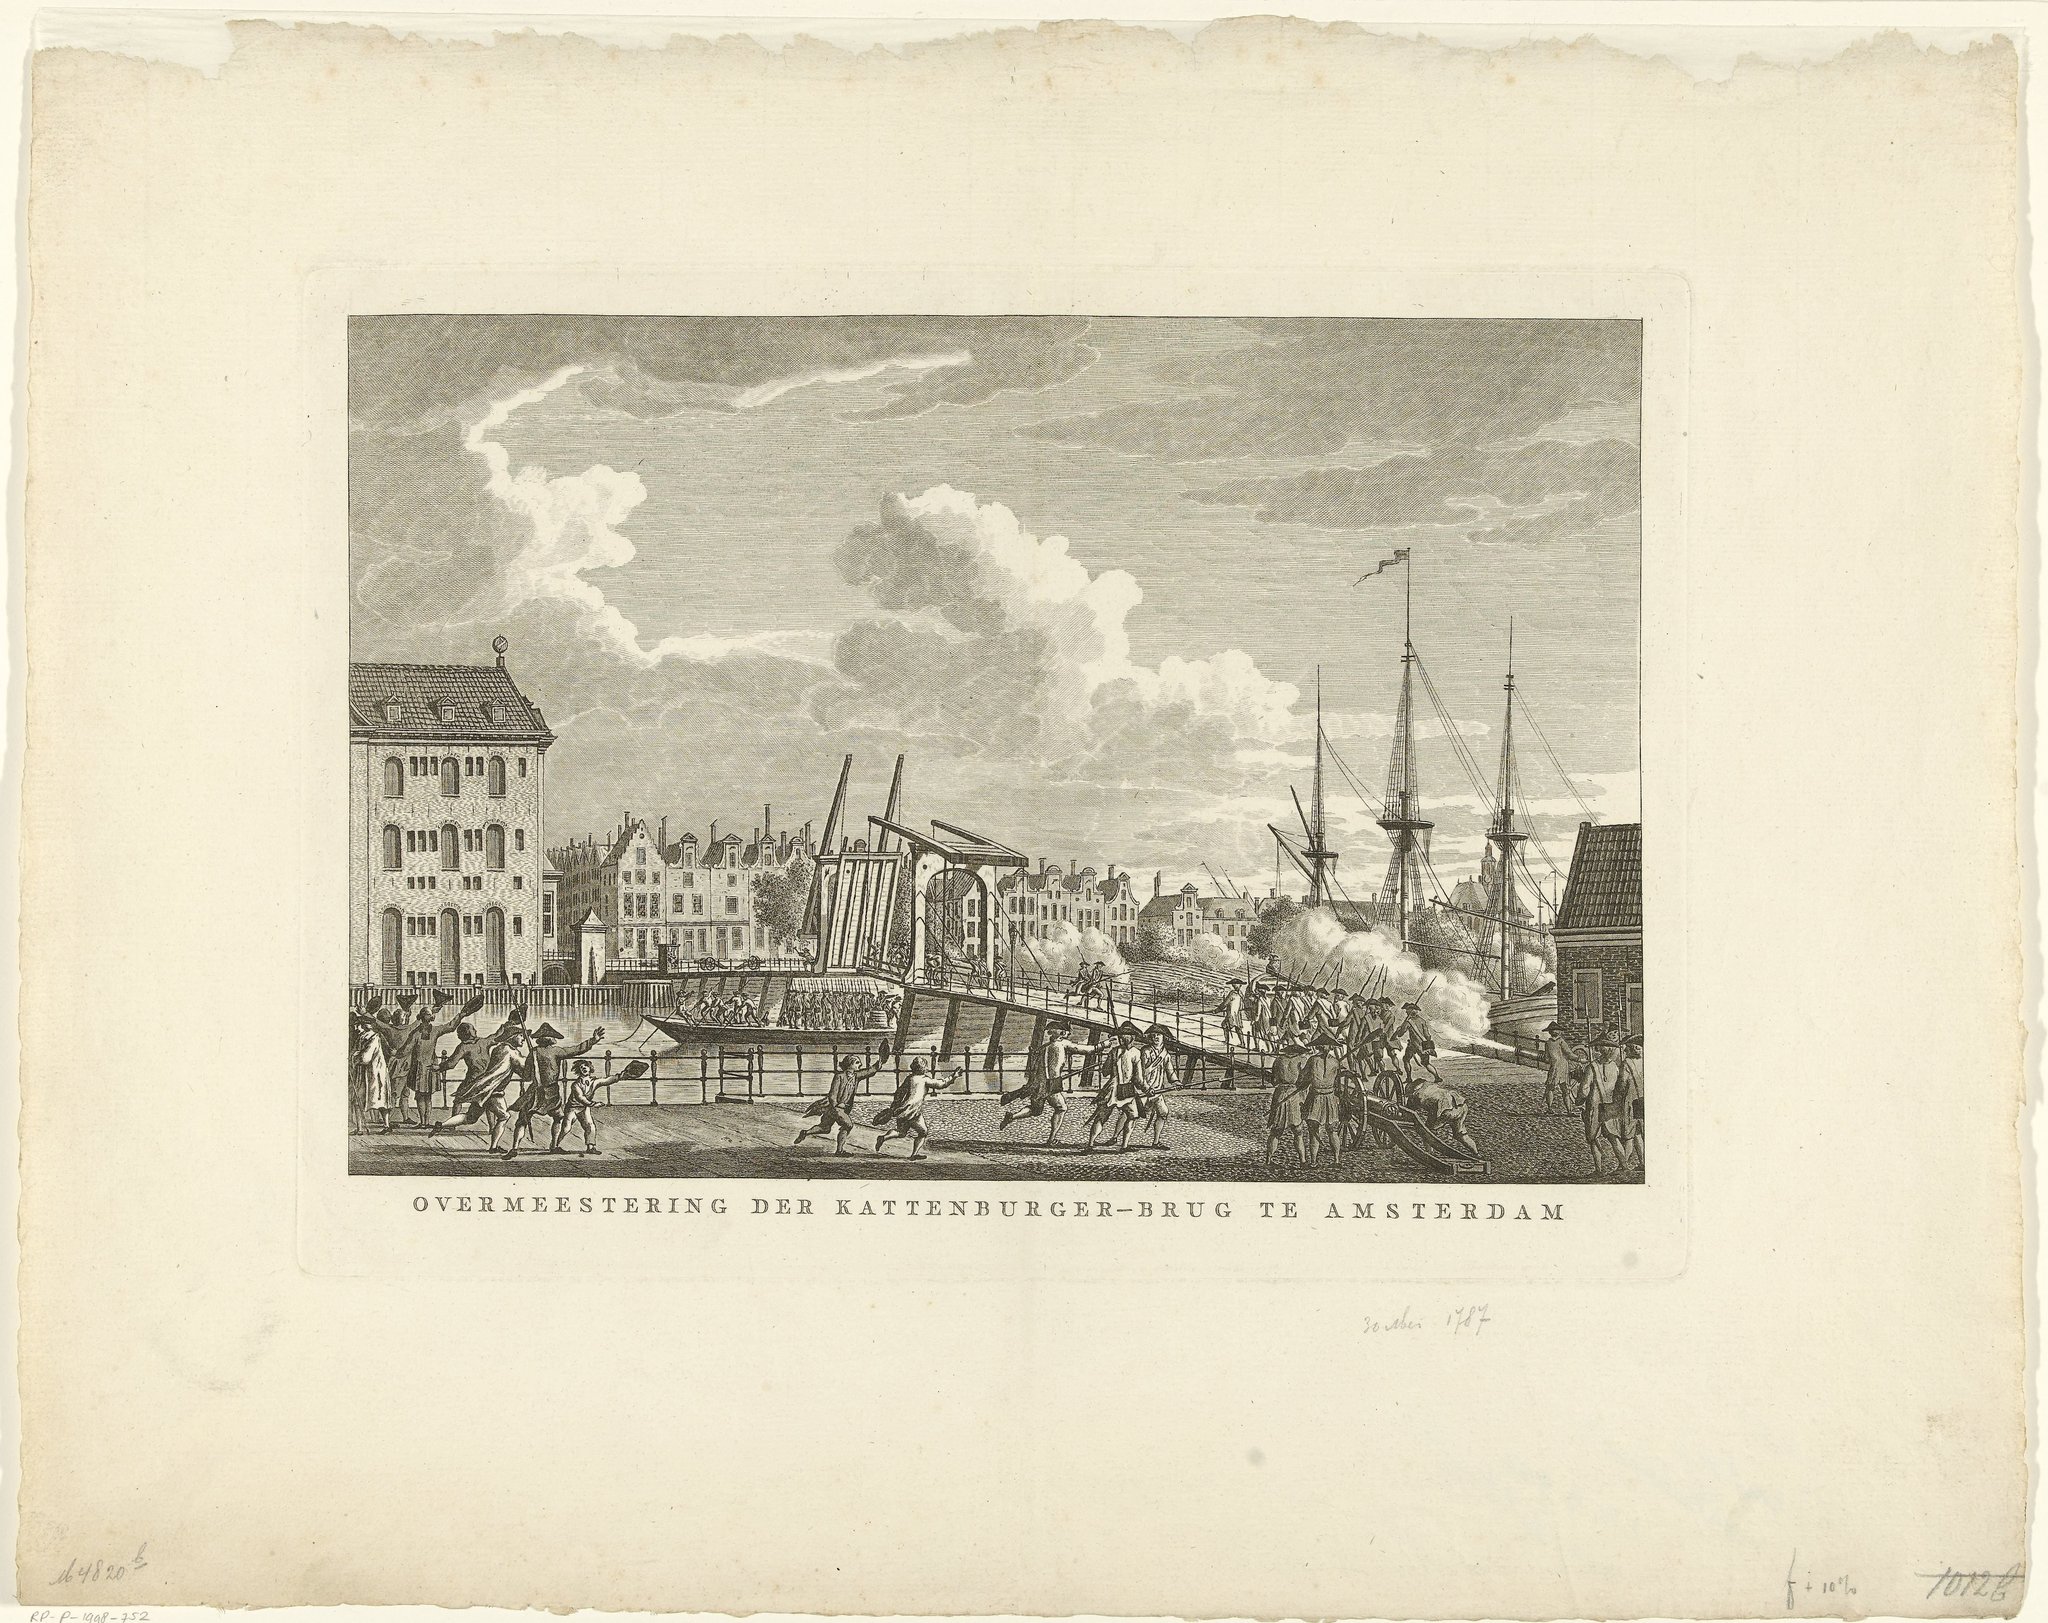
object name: print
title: Overmeestering der Kattenburger-brug te Amsterdam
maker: cornelis jacob de huyser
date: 1787-1789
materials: paper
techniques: engraving, etching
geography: amsterdam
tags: drawbridge ~ fortified city, being attacked; defence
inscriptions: collector's mark: Lugt 2228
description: Aanval op Kattenburg, Amsterdam, door de patriotten. De inwoners van Kattenburg, veelal scheepsbouwers, waren aanhangers van stadhouder Willem V. Toen de patriotten in 1787 aan de macht kwamen stuurden zij de schutterij naar Kattenburg. Bij de Kattenburgerbrug ontstond op 30 mei 1787 een gevecht tussen de twee partijen.